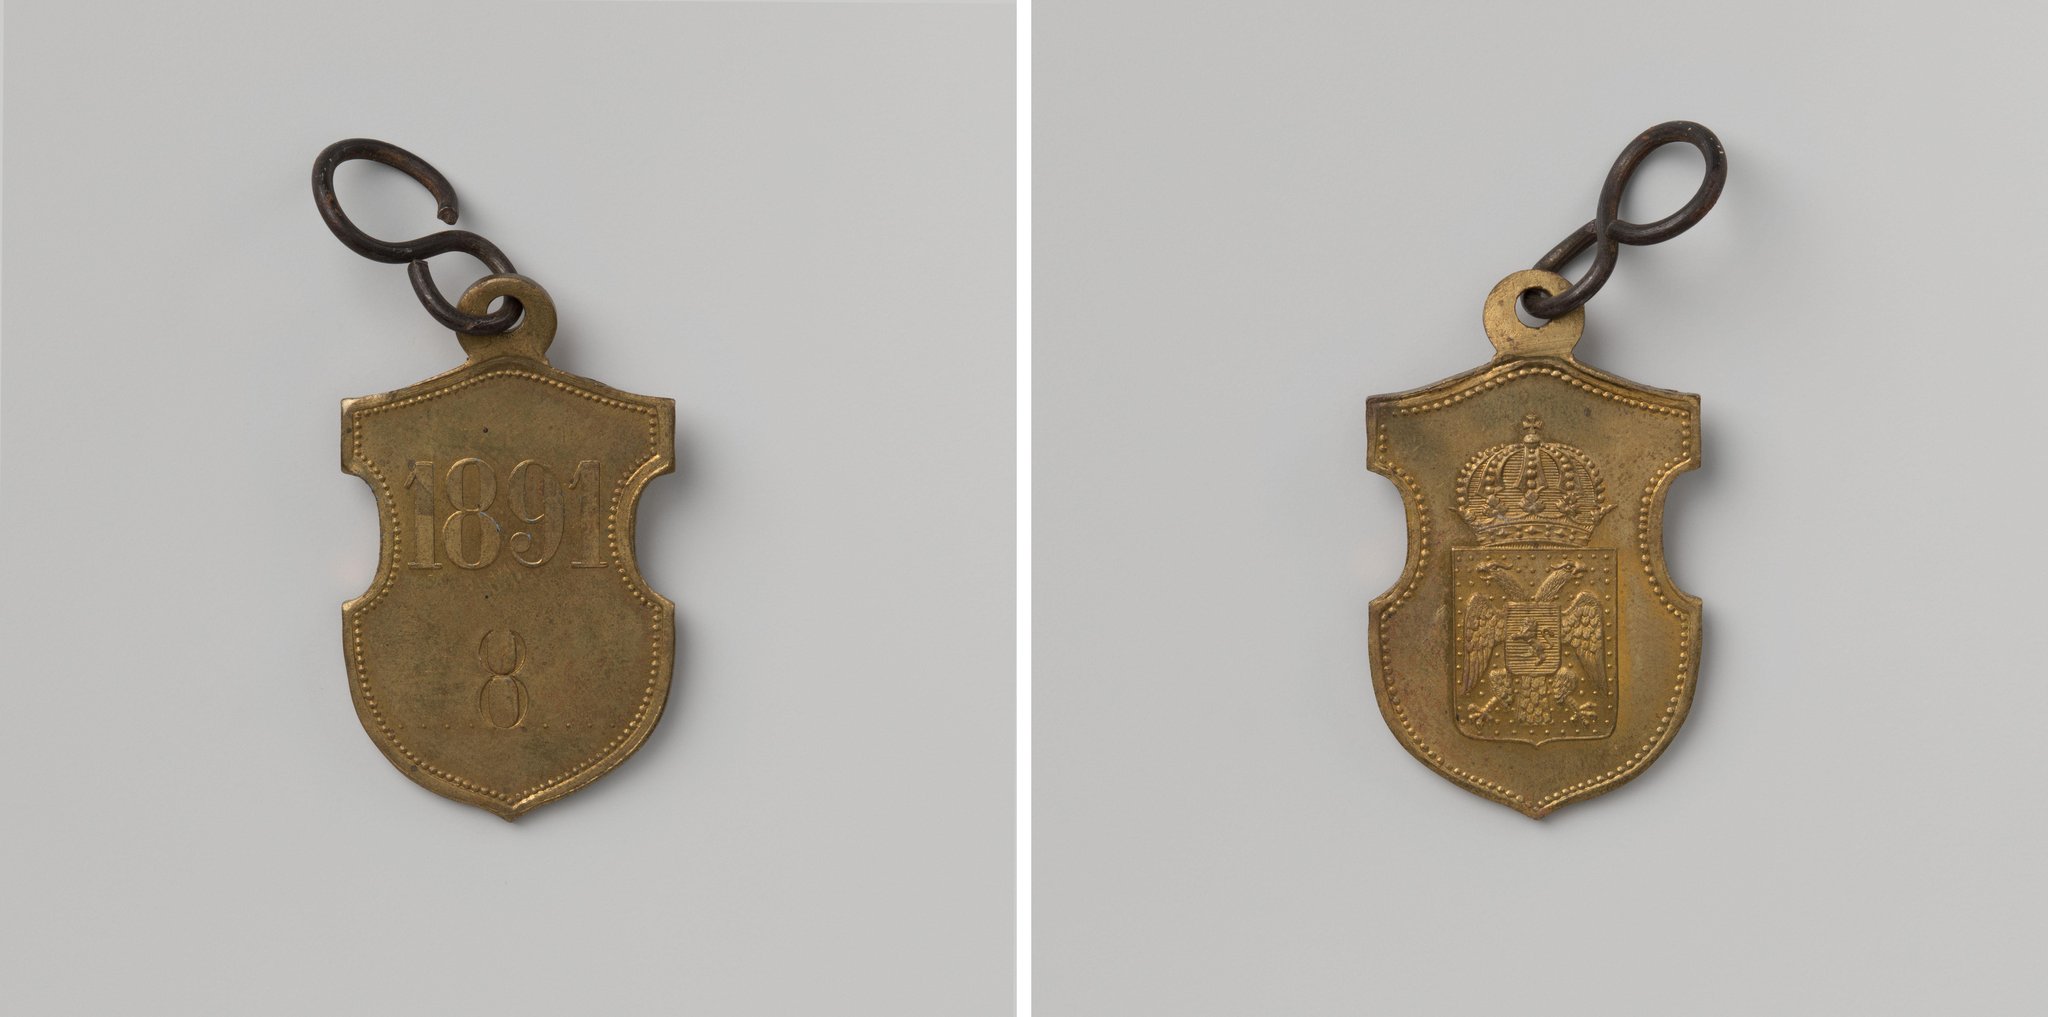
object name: tax token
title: Loodje met no. 8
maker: Anonymous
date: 1891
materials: brass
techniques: striking